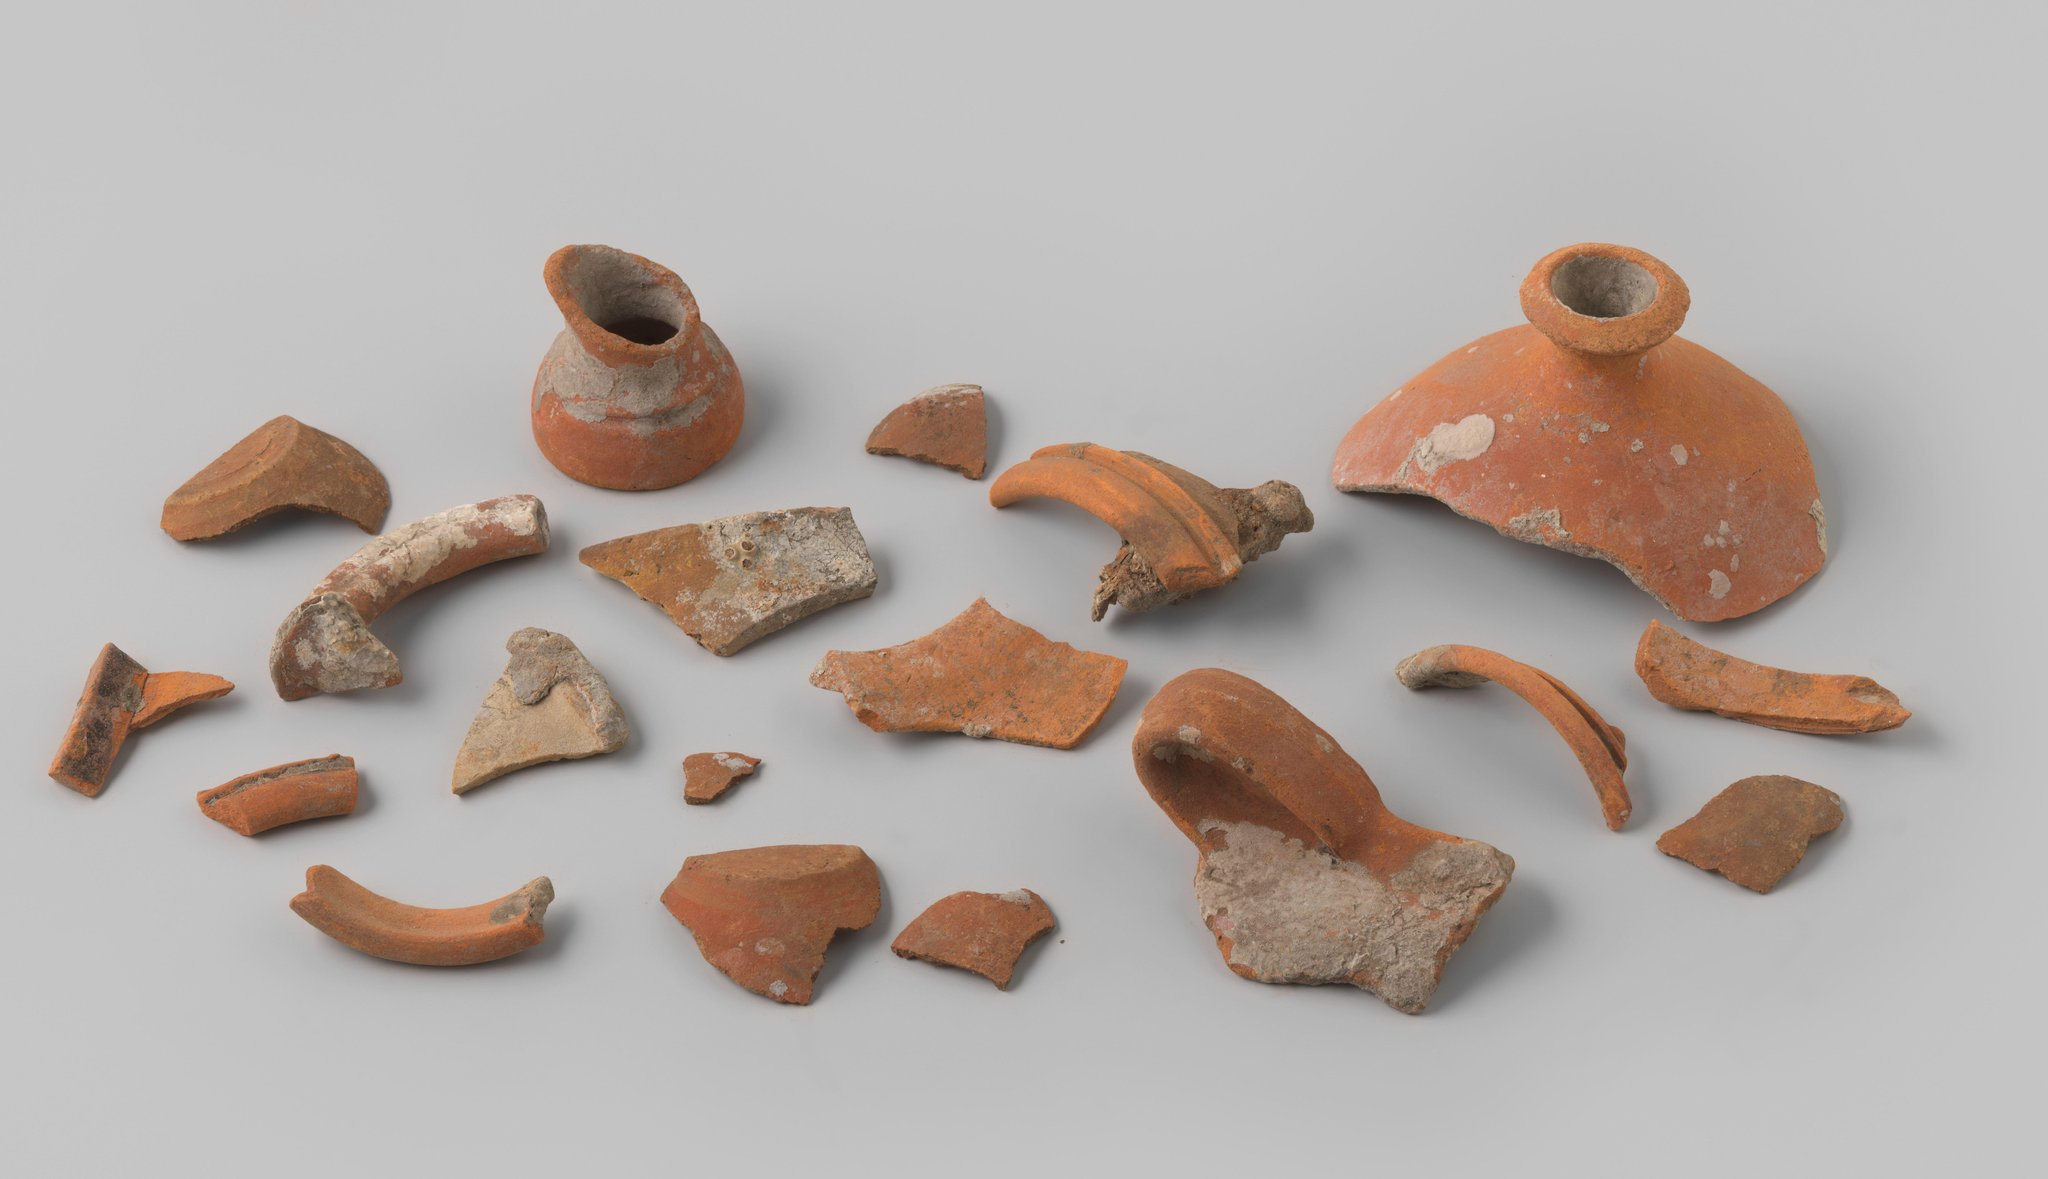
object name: sherd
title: Zak met scherven van aardewerk uit V.O.C.-schip de 'Witte Leeuw'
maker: Anonymous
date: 1613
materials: earthenware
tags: verenigde oostindische compagnie, sint-helena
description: Zak met scherven van roodbakkend aardewerk en steengoed uit V.O.C.-schip de 'Witte Leeuw'.